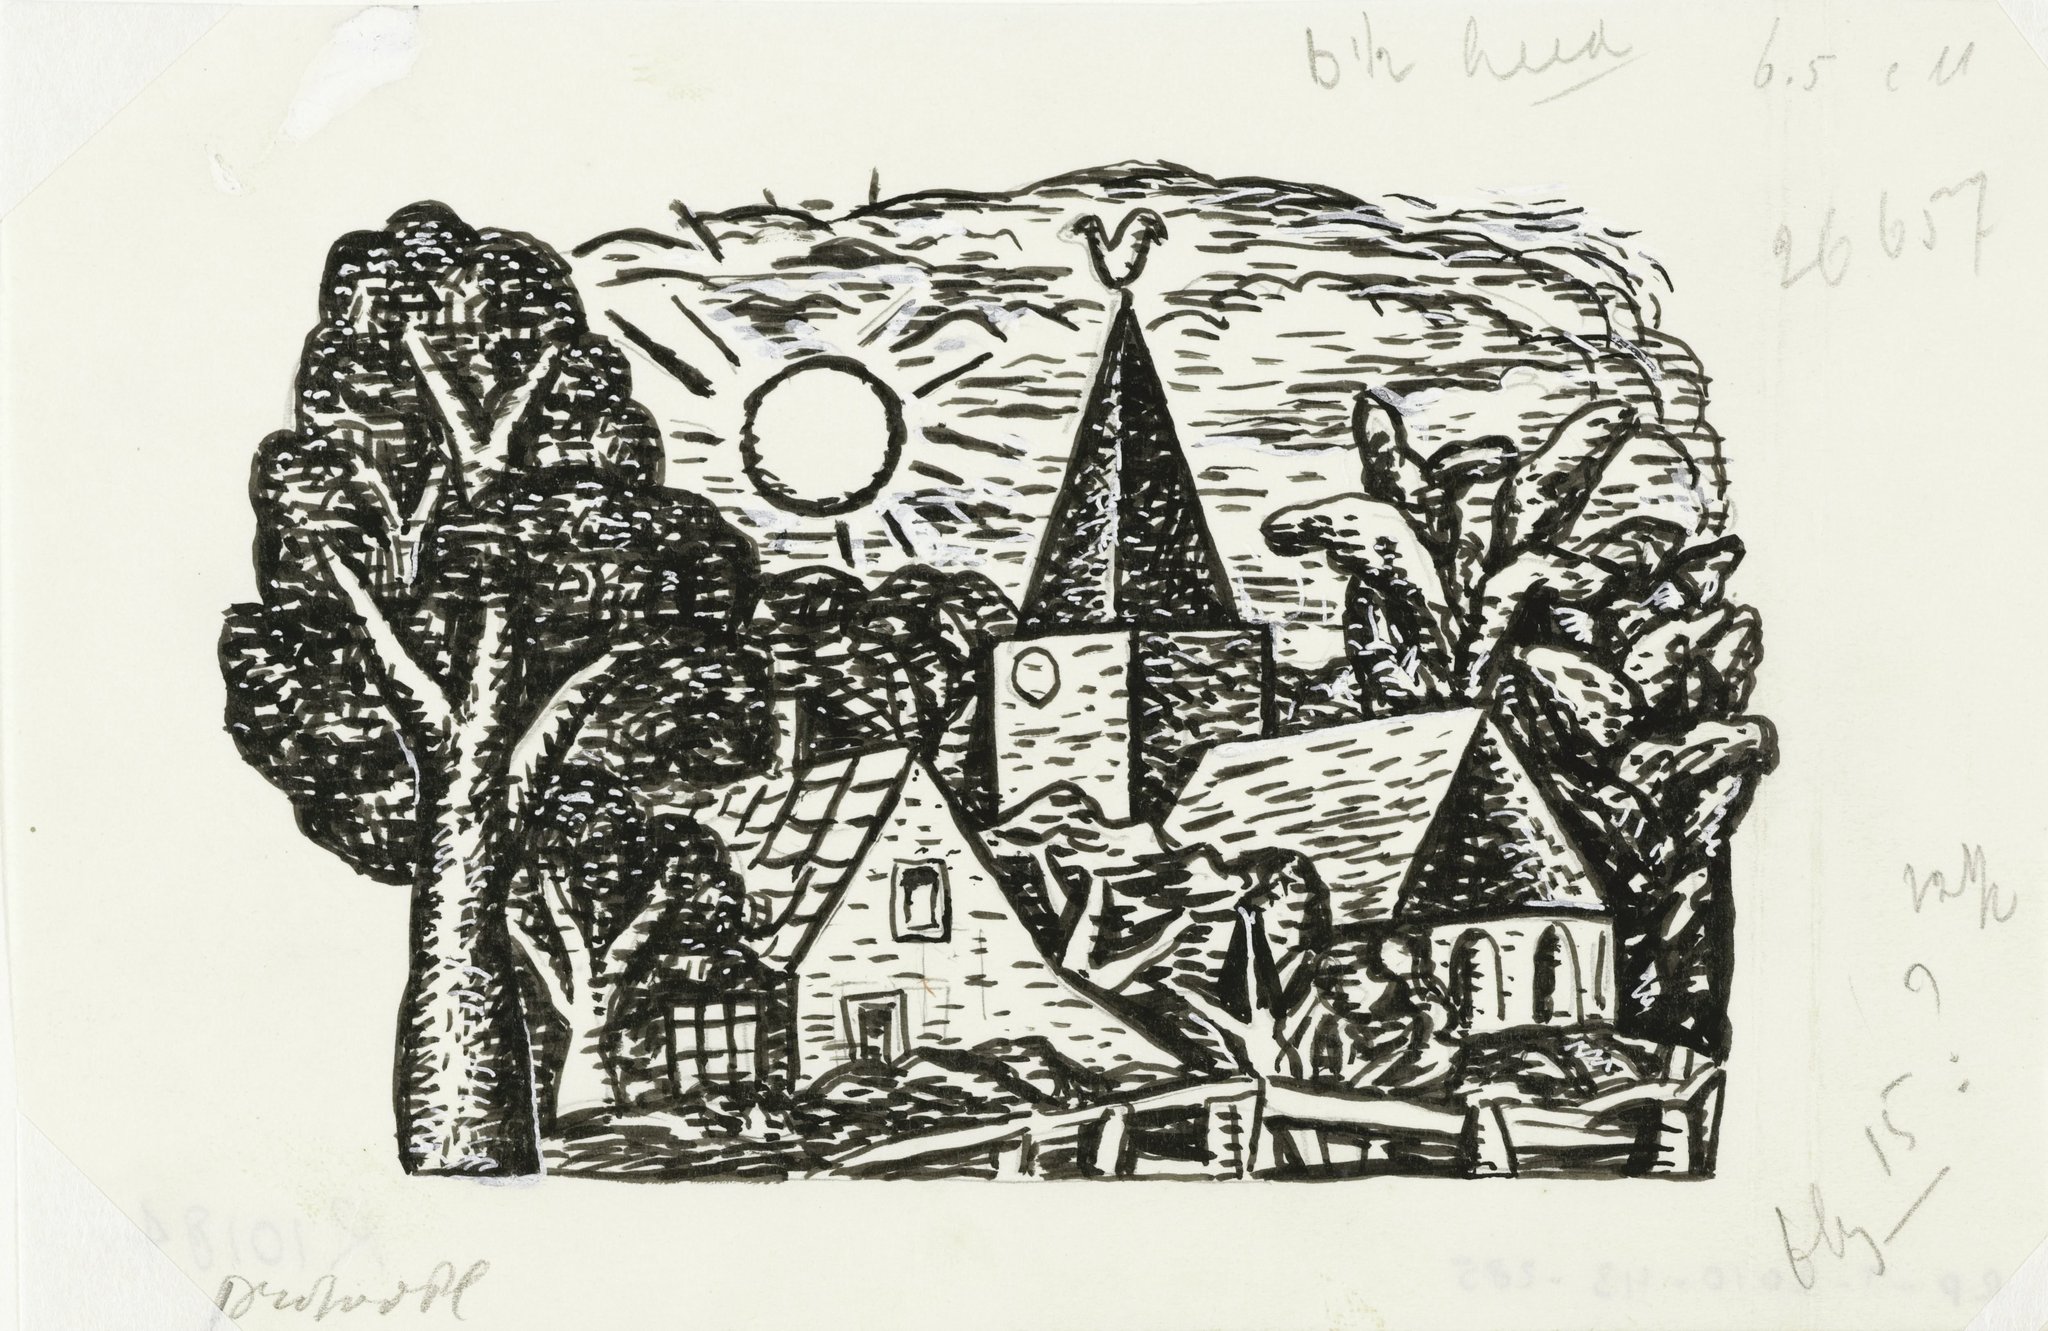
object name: drawing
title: Zonder titel (Dorpsgezicht met kerk en zon, vignet voor biografie van Gestel door Prof. W. van der Pluym)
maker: leo gestel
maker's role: draughtsman, print maker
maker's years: 1881-1941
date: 1935-1936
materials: paint, ink, paper, pencil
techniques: brush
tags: print maker, draughtsman, leo gestel, village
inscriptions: inscription: ‘61/2 breed / 6.5 c M’, inscription: ‘ProfvdPL’, number: ‘26645’, inscription: ‘blz 15 ? 12 1/2’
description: De huidige titels zijn door het museum toegekend bij gebrek aan informatie over een originele titel.